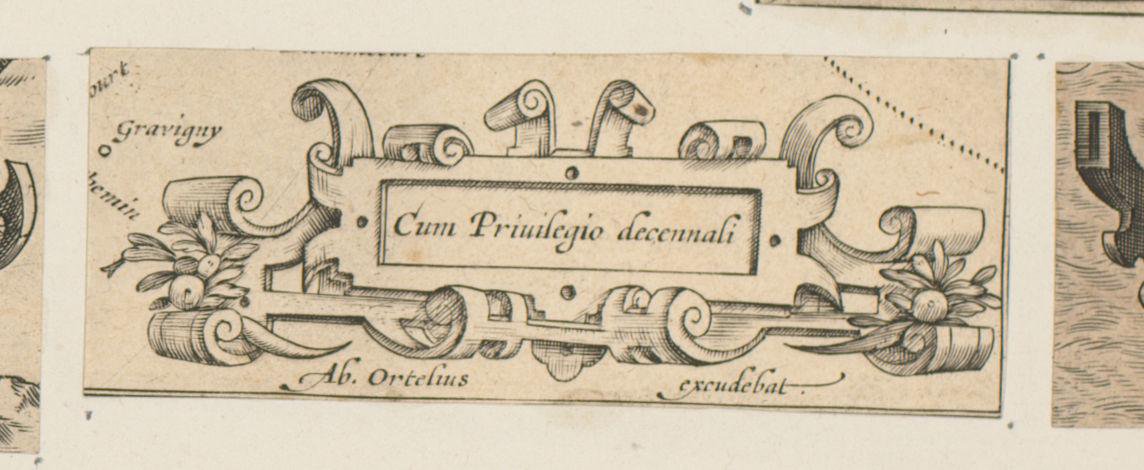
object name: album leaf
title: Theatrum Orbis Terrarum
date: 1587-1590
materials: paper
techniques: engraving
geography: antwerp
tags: fruits and vegetables ~ ornament, scrollwork, strapwork ~ ornament, ornament ~ cartouche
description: Kleine langwerpige cartouche met rolwerk en trossen fruit. De cartouche is een fragment van een kaart van Lotharingen. De prent maakt deel uit van een album.